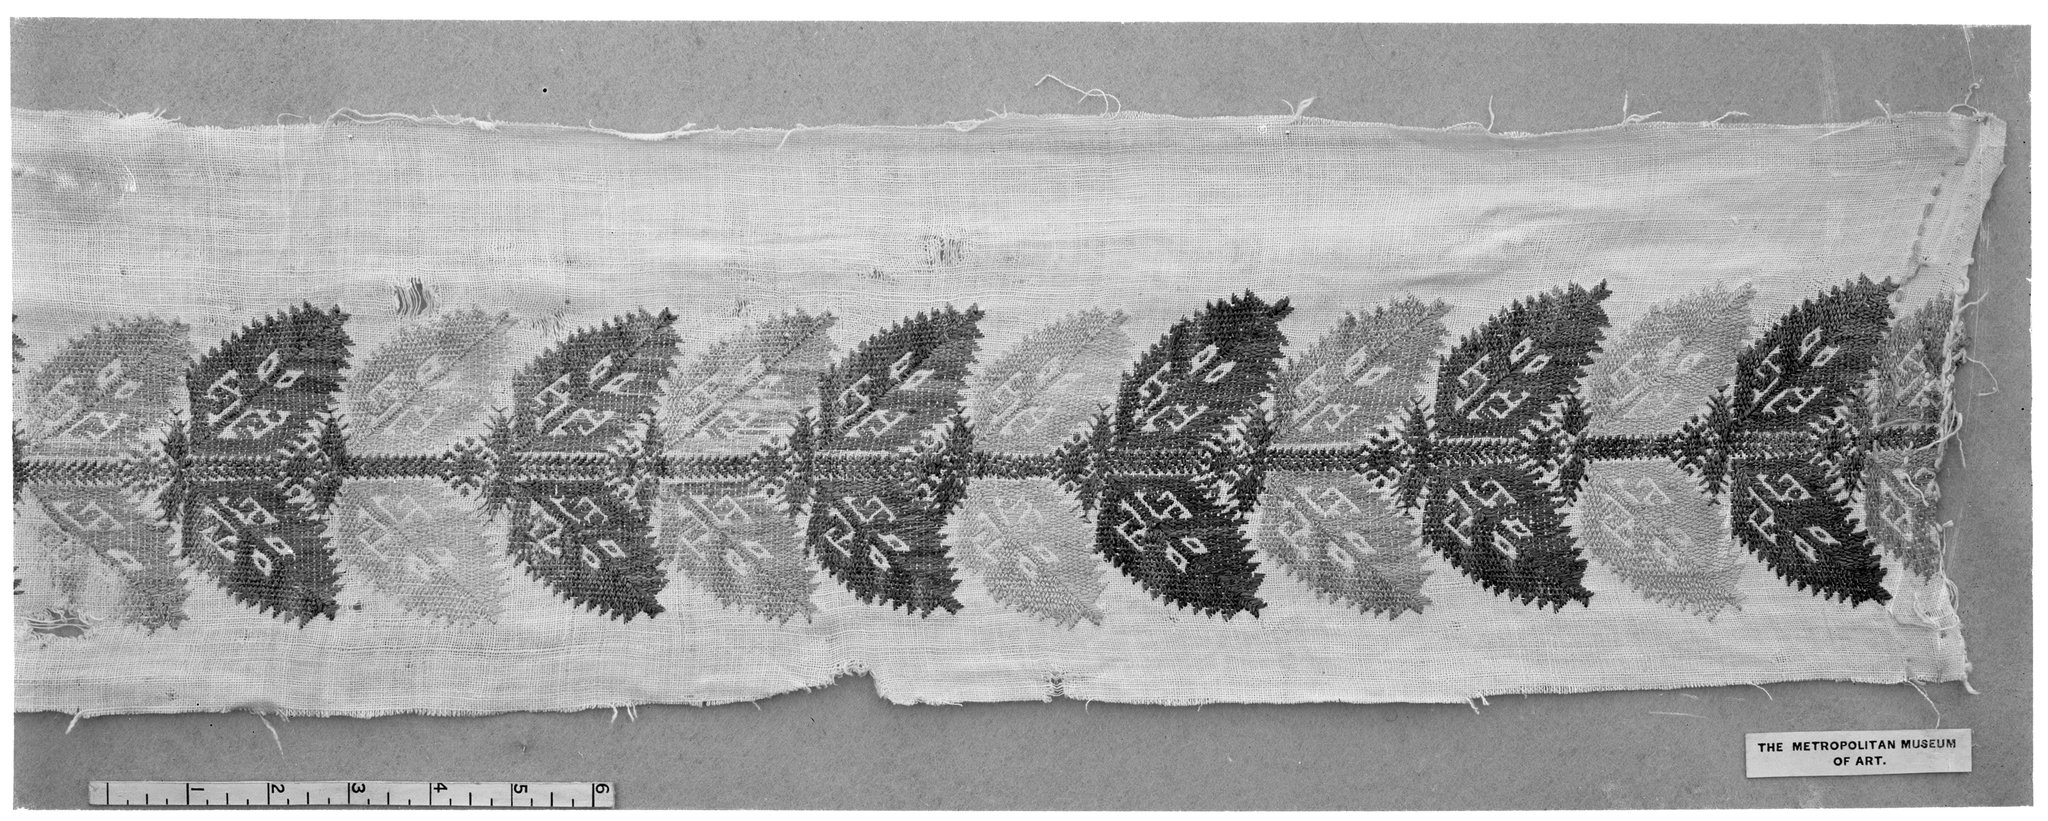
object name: strip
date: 1701-1800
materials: linen, silk